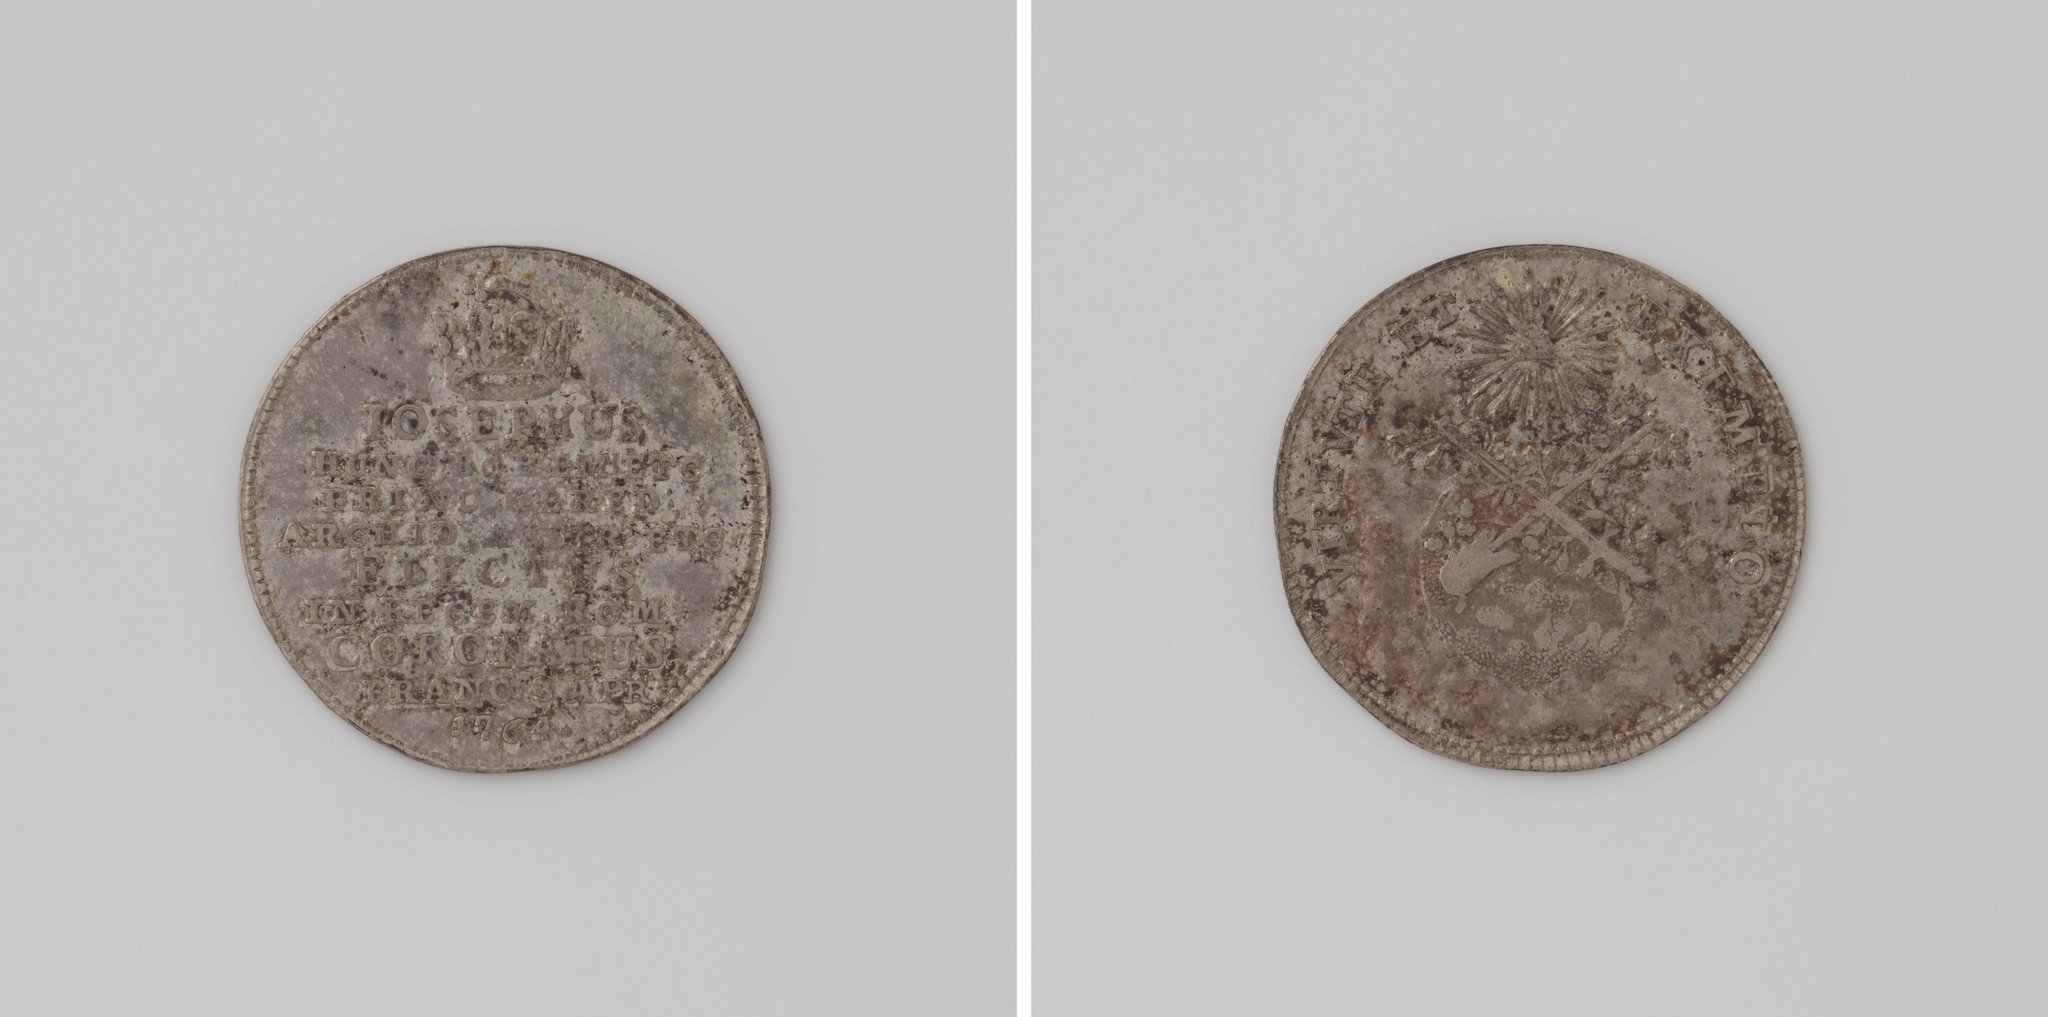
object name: strooipenning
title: Kroning van Jozef II tot Duits keizer te Frankfurt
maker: Anonymous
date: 1764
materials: silver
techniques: striking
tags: jozef ii (duits keizer)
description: Zilveren penning. Voorzijde: opschrift ondr kroon. Keerzijde: spade en zwaard omwonden met olijftakken voor wereldbol binnen wolken, beschenen door stralende driehoek binnen omschrift